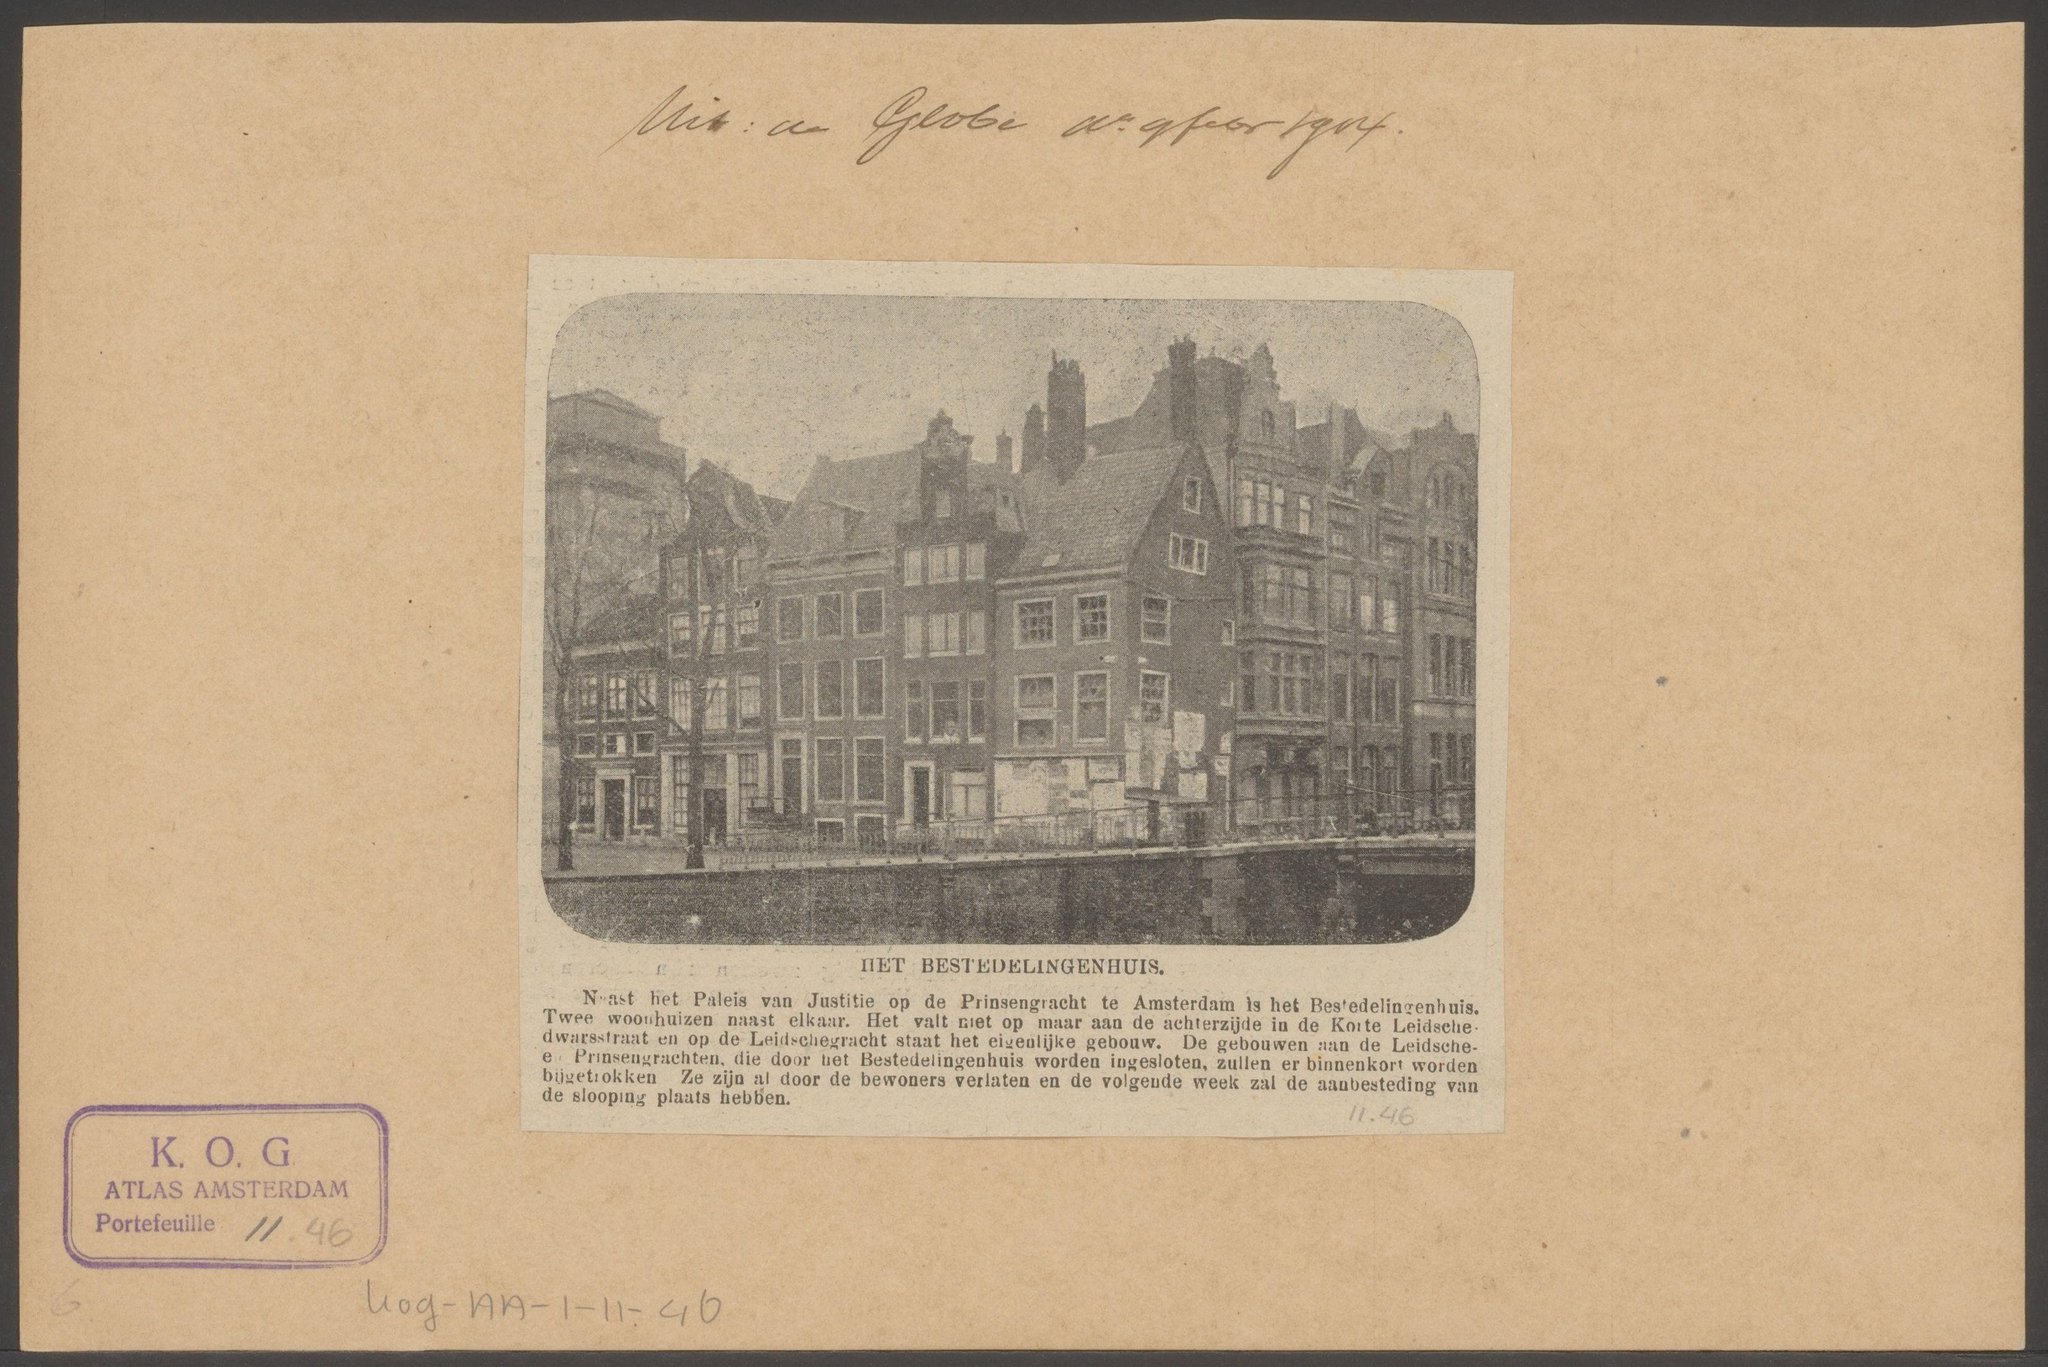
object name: photomechanical print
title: Gezicht op het Aalmoezeniersweeshuis aan de Prinsengracht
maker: Anonymous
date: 1914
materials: paper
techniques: letterpress printing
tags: city-view in general; 'veduta', canal, façade (of house or building), orphanage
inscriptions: collector's mark: ‘11.46’ Lugt 1641b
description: Onderwerpsrubriek binnen de Atlas Amsterdam: Prinsengracht, Korte Prinsengracht, Prins Hendrikkade. Zie ook Portefeuille 1: gezichten van het IJ op de stad.